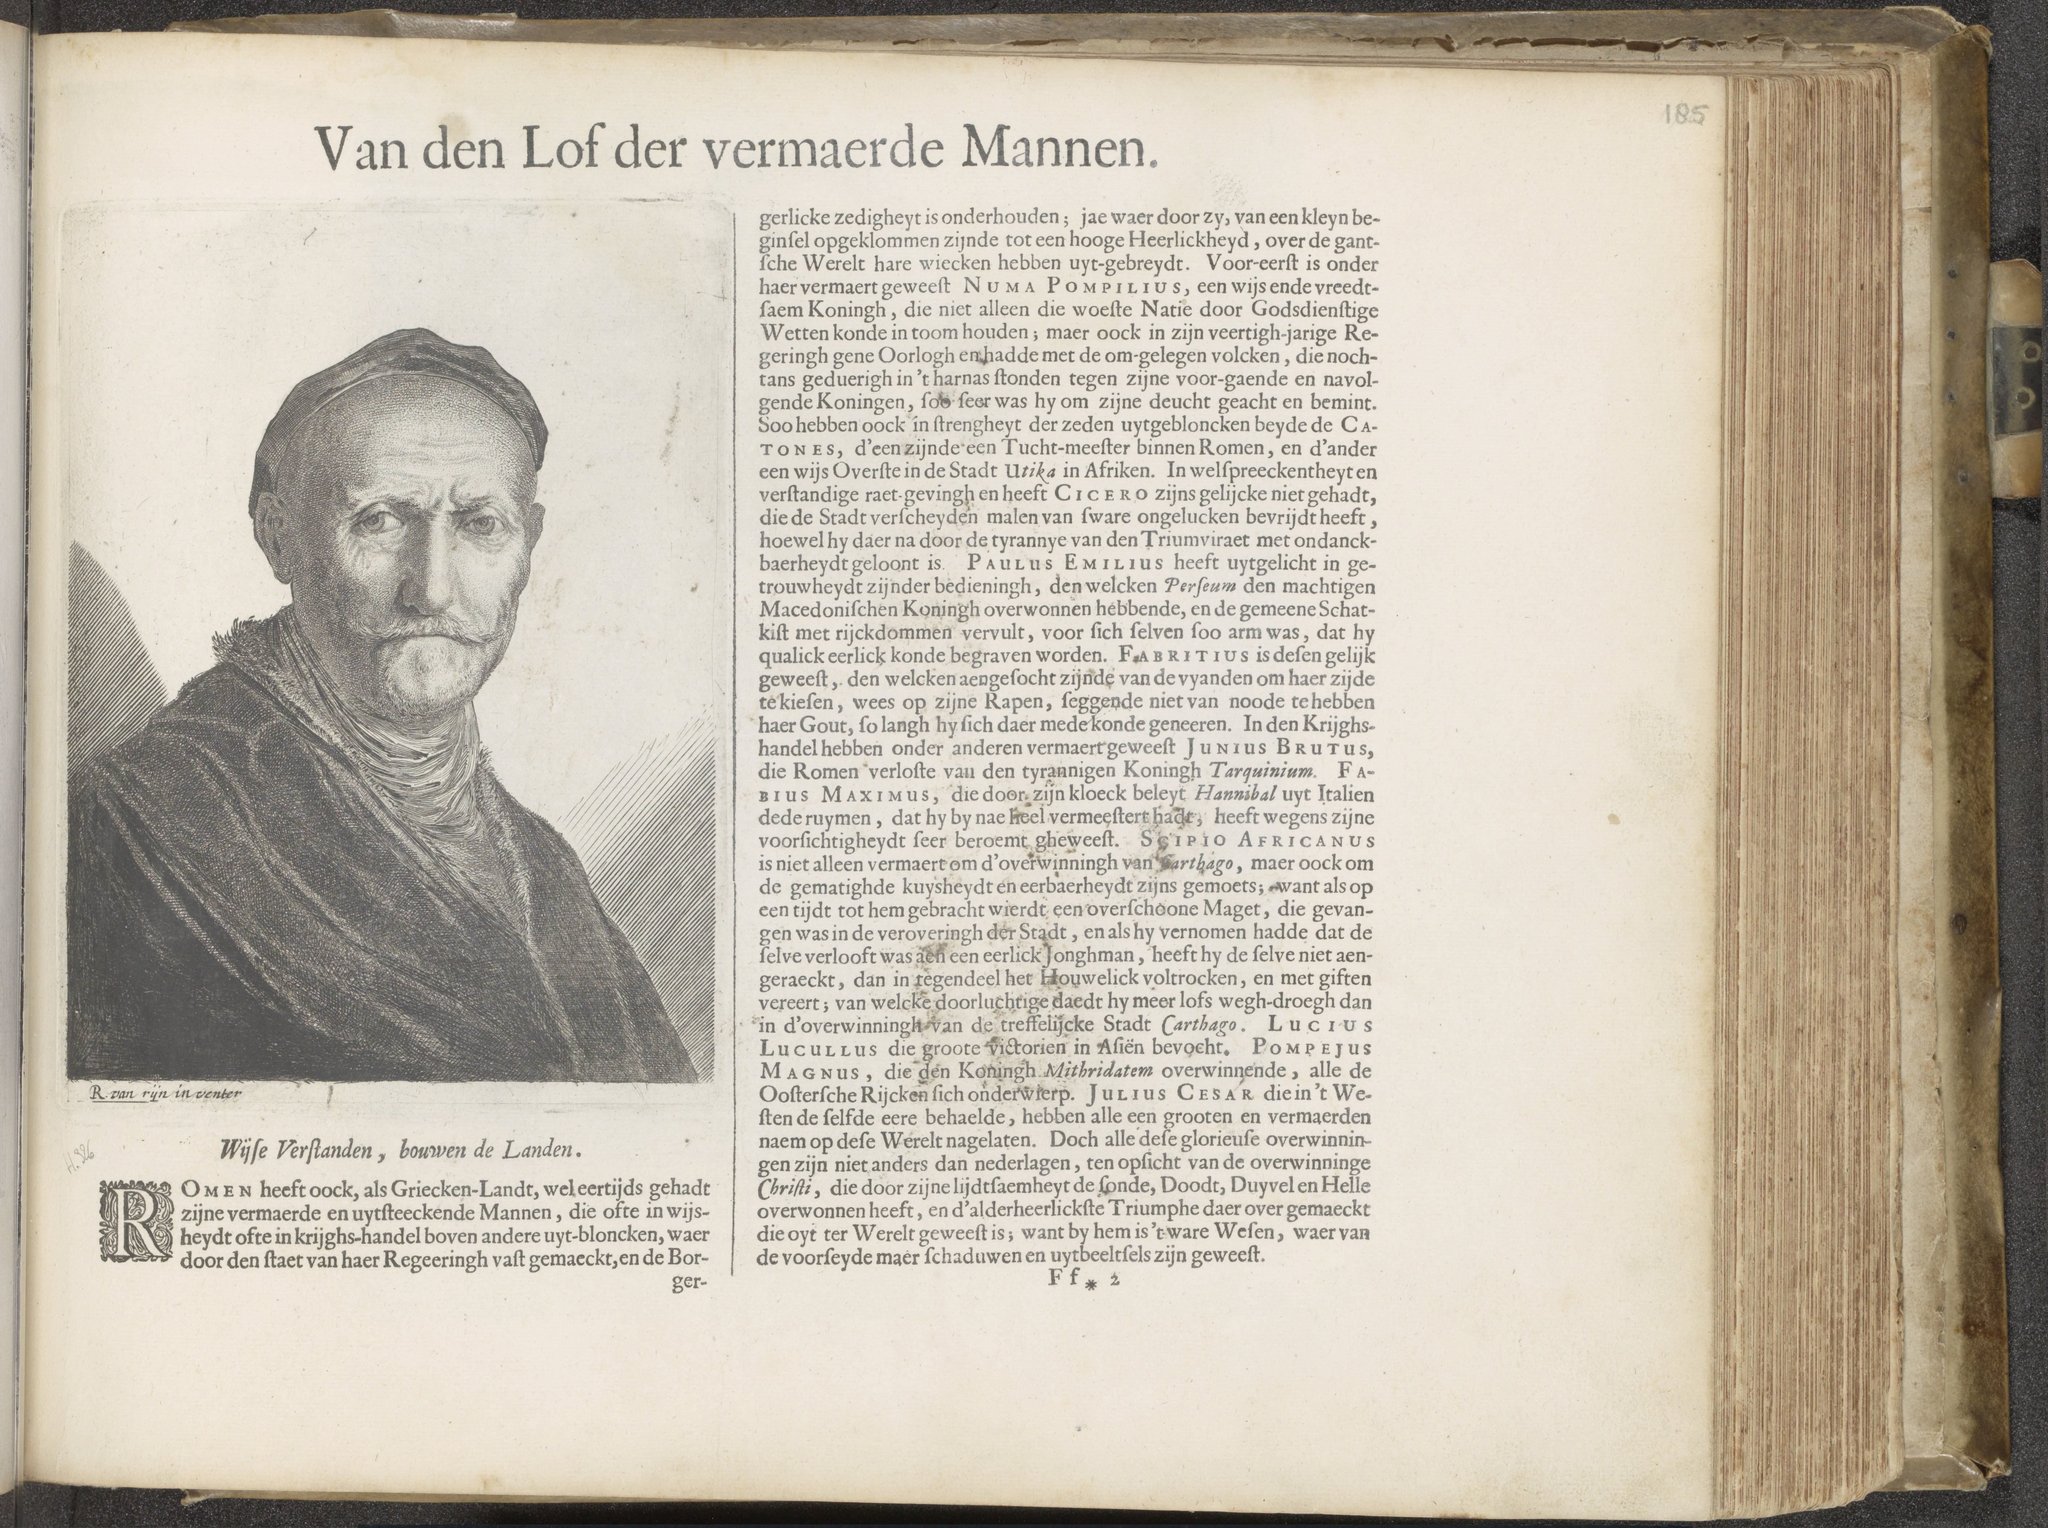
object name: text sheet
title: Portret van een oudere man met een baret op zijn hoofd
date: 1633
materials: paper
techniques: engraving, etching, letterpress printing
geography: amsterdam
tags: initial, old man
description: Portret van een oudere man met een baret op zijn hoofd, in dit album gebruikt als afbeelding van Numa Pompilius of Cicero. De begeleidende tekst begint met een gedecoreerde initiaal R. Het blad maakt deel uit van een album.